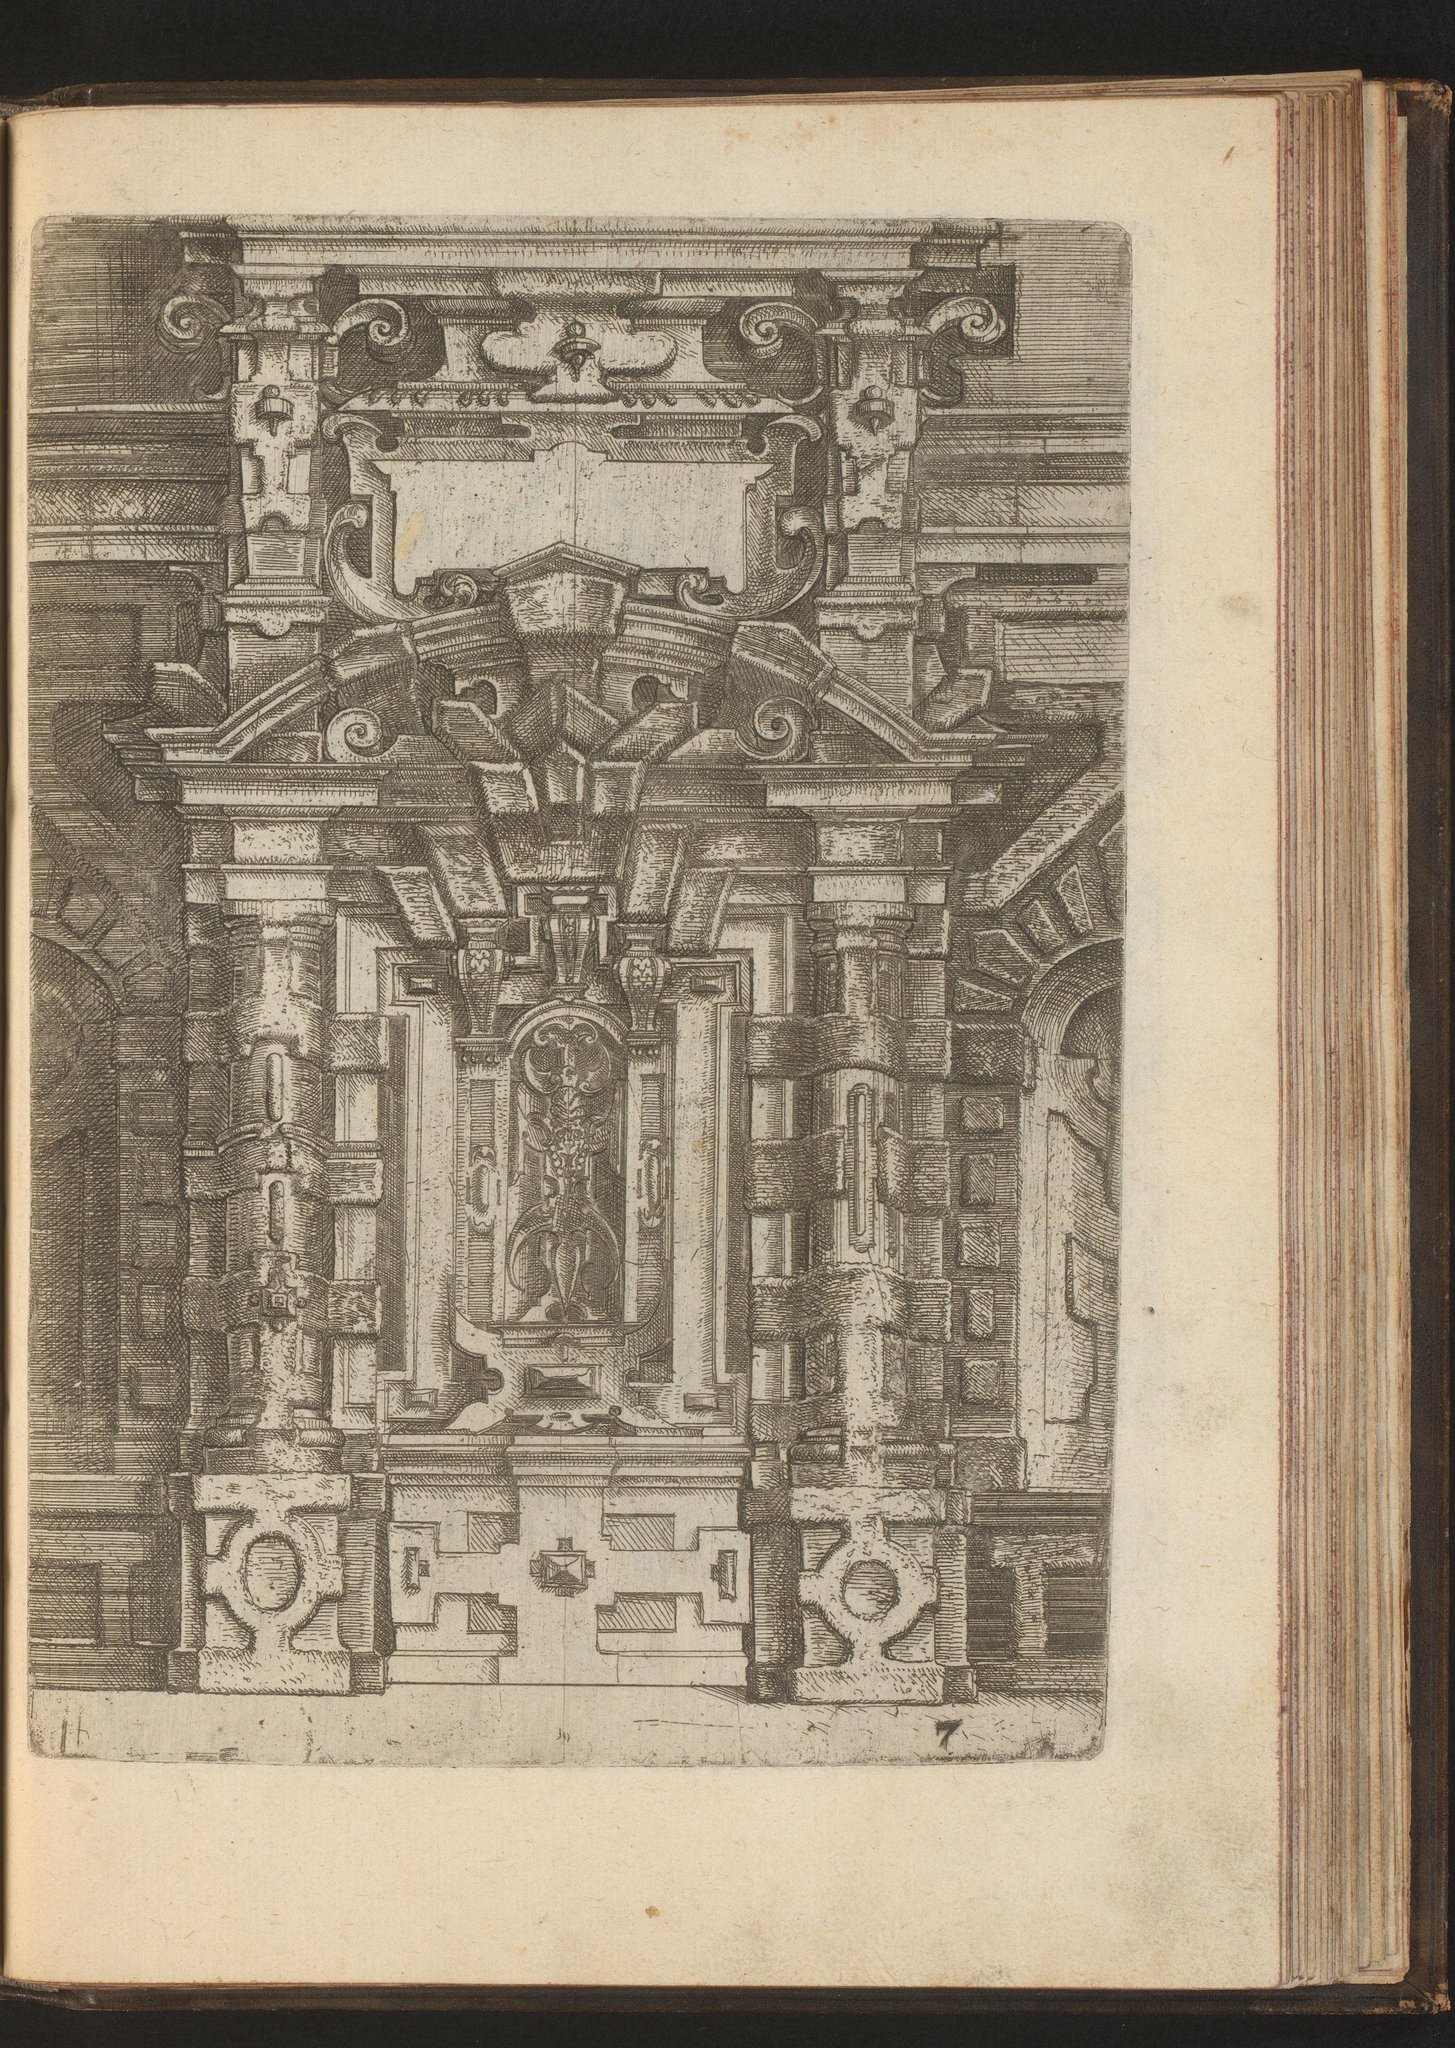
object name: book illustration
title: Architectura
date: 1593-1595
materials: paper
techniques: etching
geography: straatsburg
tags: rustication ~ surface decorations (architecture), tuscan order ~ architecture, 'laub- und bandelwerk' ~ ornament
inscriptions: collector's mark: Lugt 2228, collector's mark: Lugt 2760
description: Prent gebruikt in: Dietterlin, Wendel (I). Wendel Dietterlin, Architectura de Polstium seu Portalium ornatu uario Liber II. Straatsburg: Bernhard Jobin, 1594.